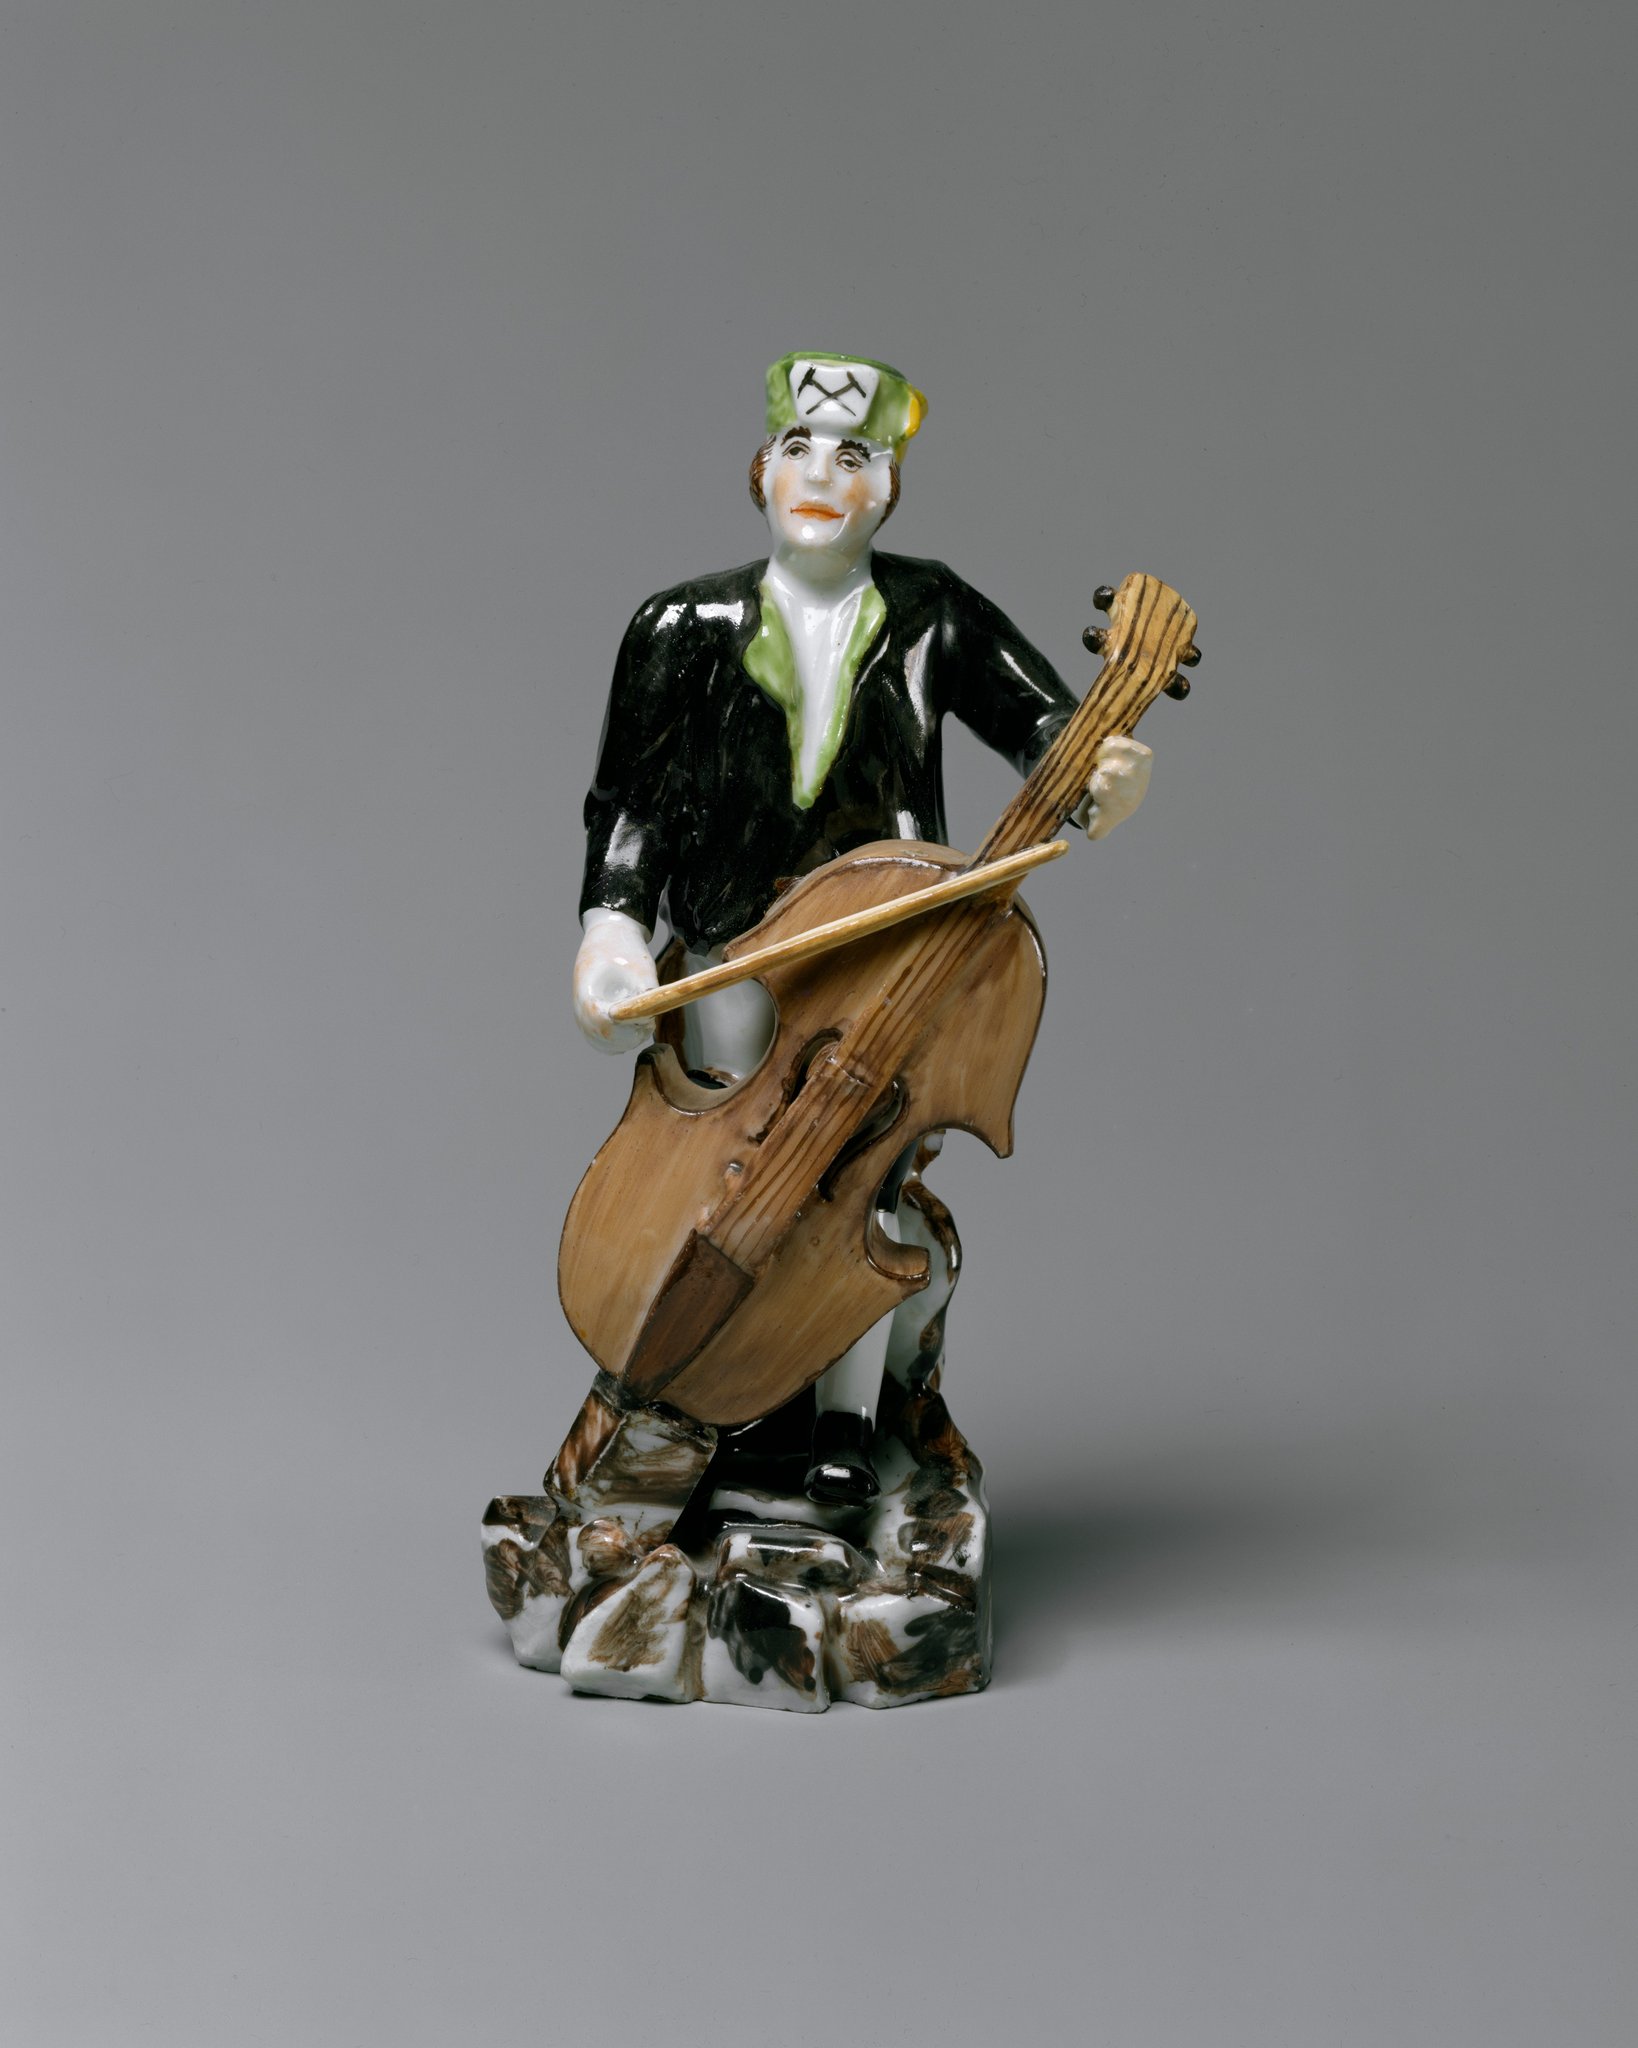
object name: figure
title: Miner Playing the Cello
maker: meissen manufactory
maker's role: manufactory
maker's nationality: german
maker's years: 1710-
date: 1730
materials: hard paste porcelain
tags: men,cellos